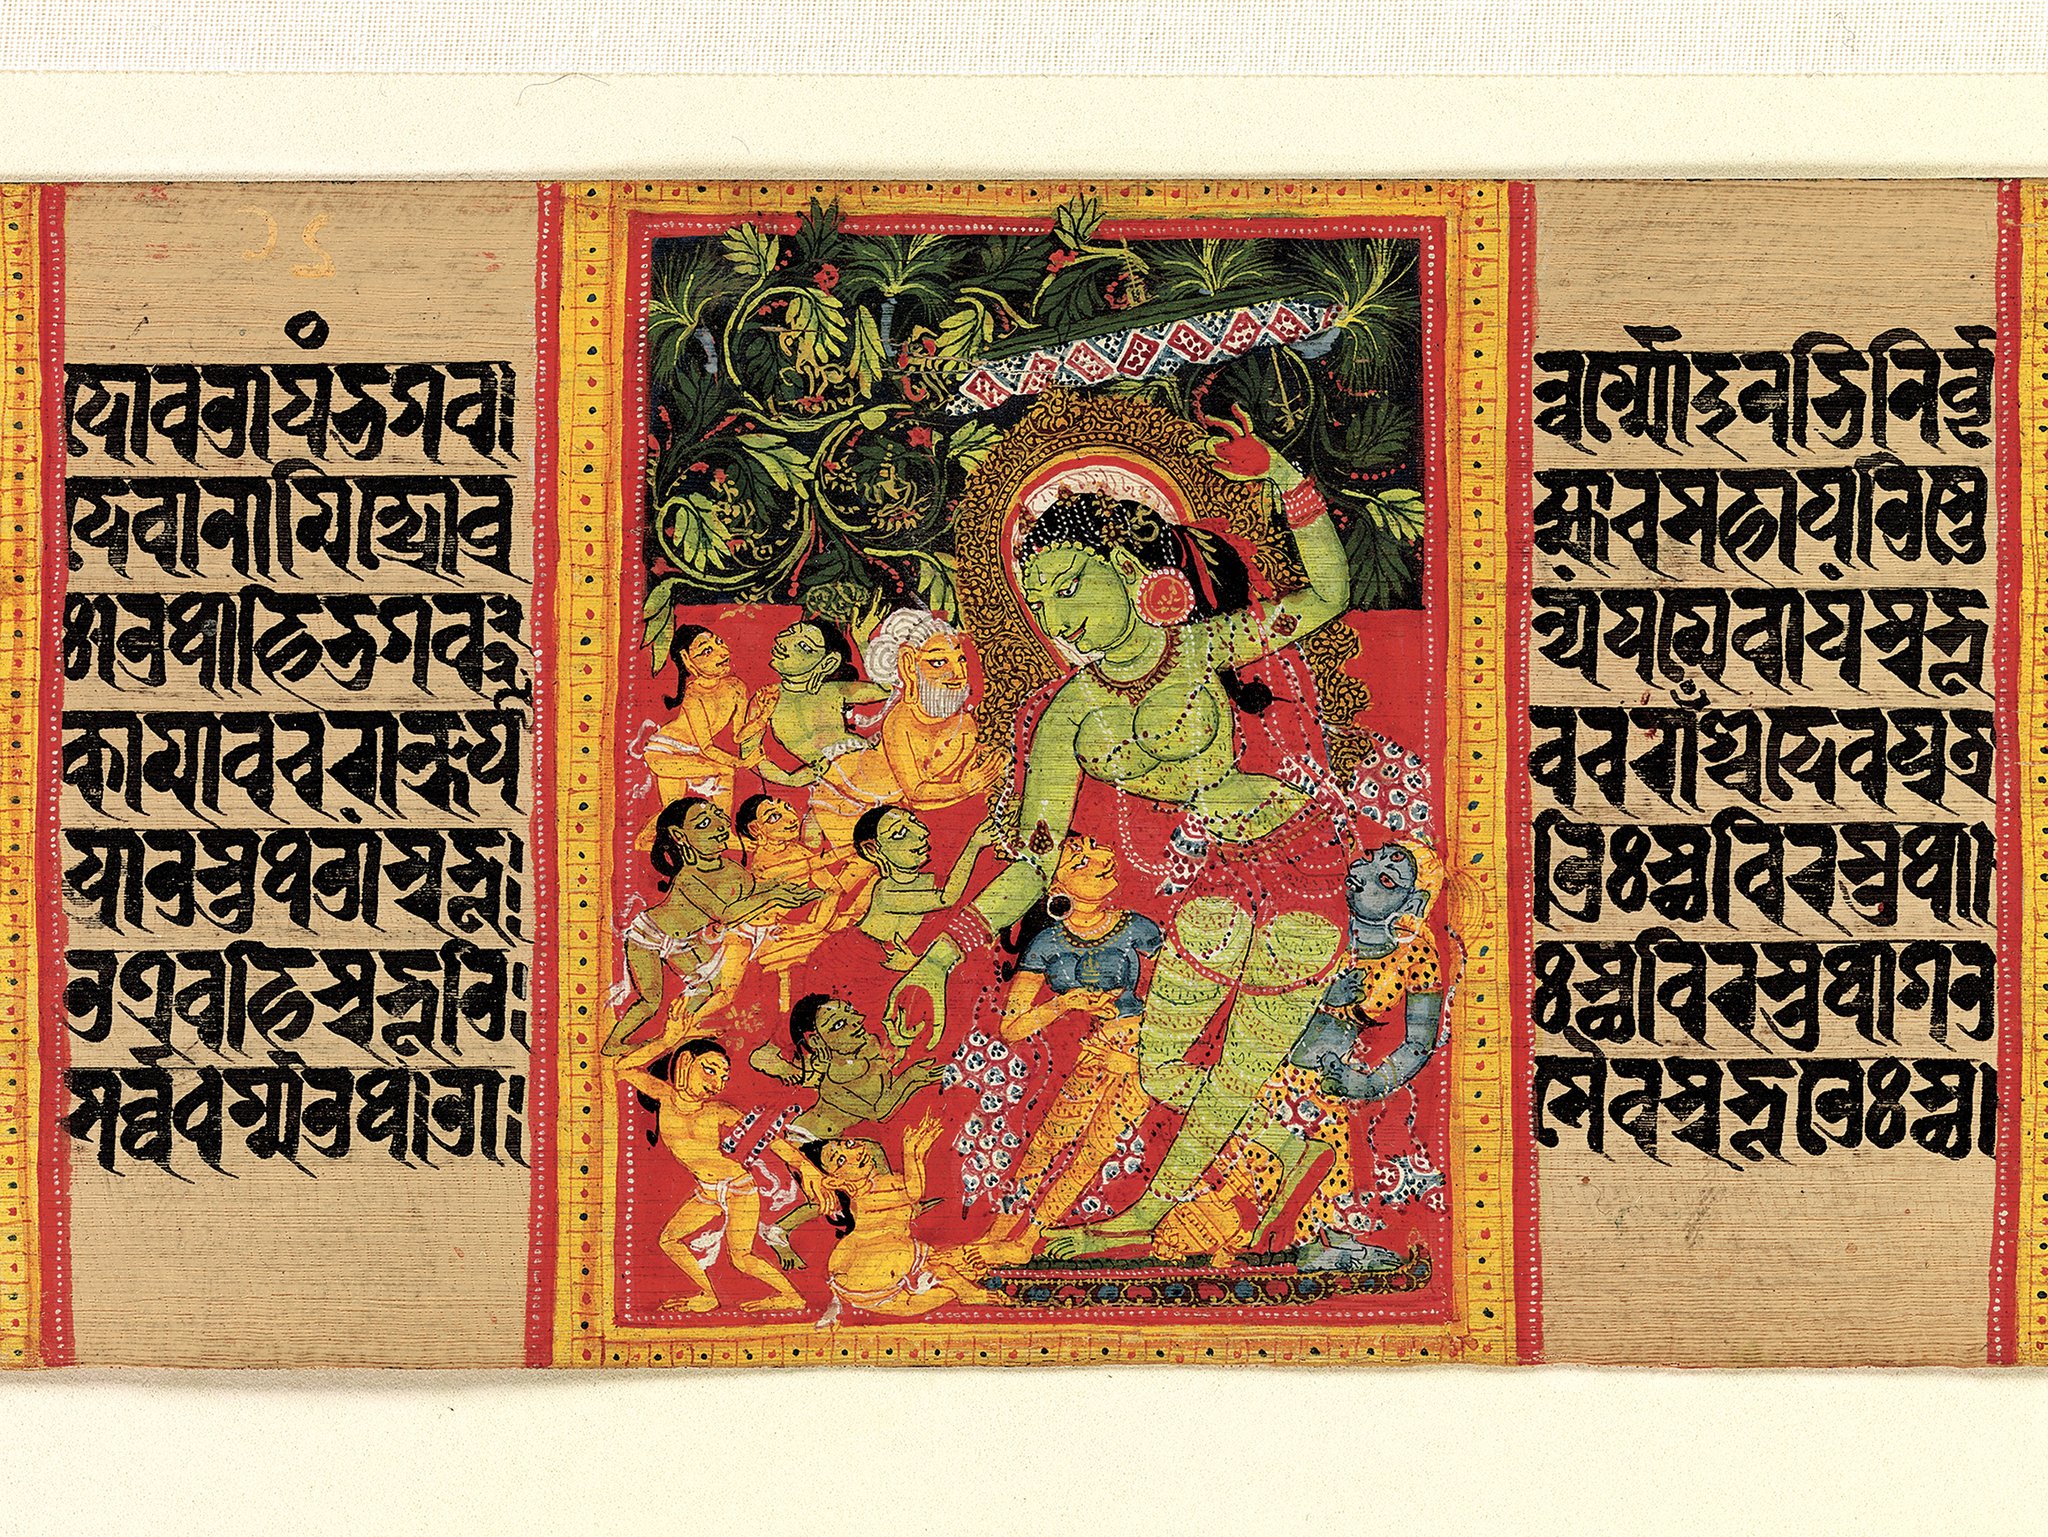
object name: folio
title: Green Tara Dispensing Boons to Ecstatic Devotees: Folio from a Manuscript of the Ashtasahasrika Prajnaparamita (Perfection of Wisdom)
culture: indian or west bengali or bangladeshi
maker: mahavihara master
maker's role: artist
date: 1101-1133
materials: leaf, watercolor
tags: buddhism,bodhisattvas